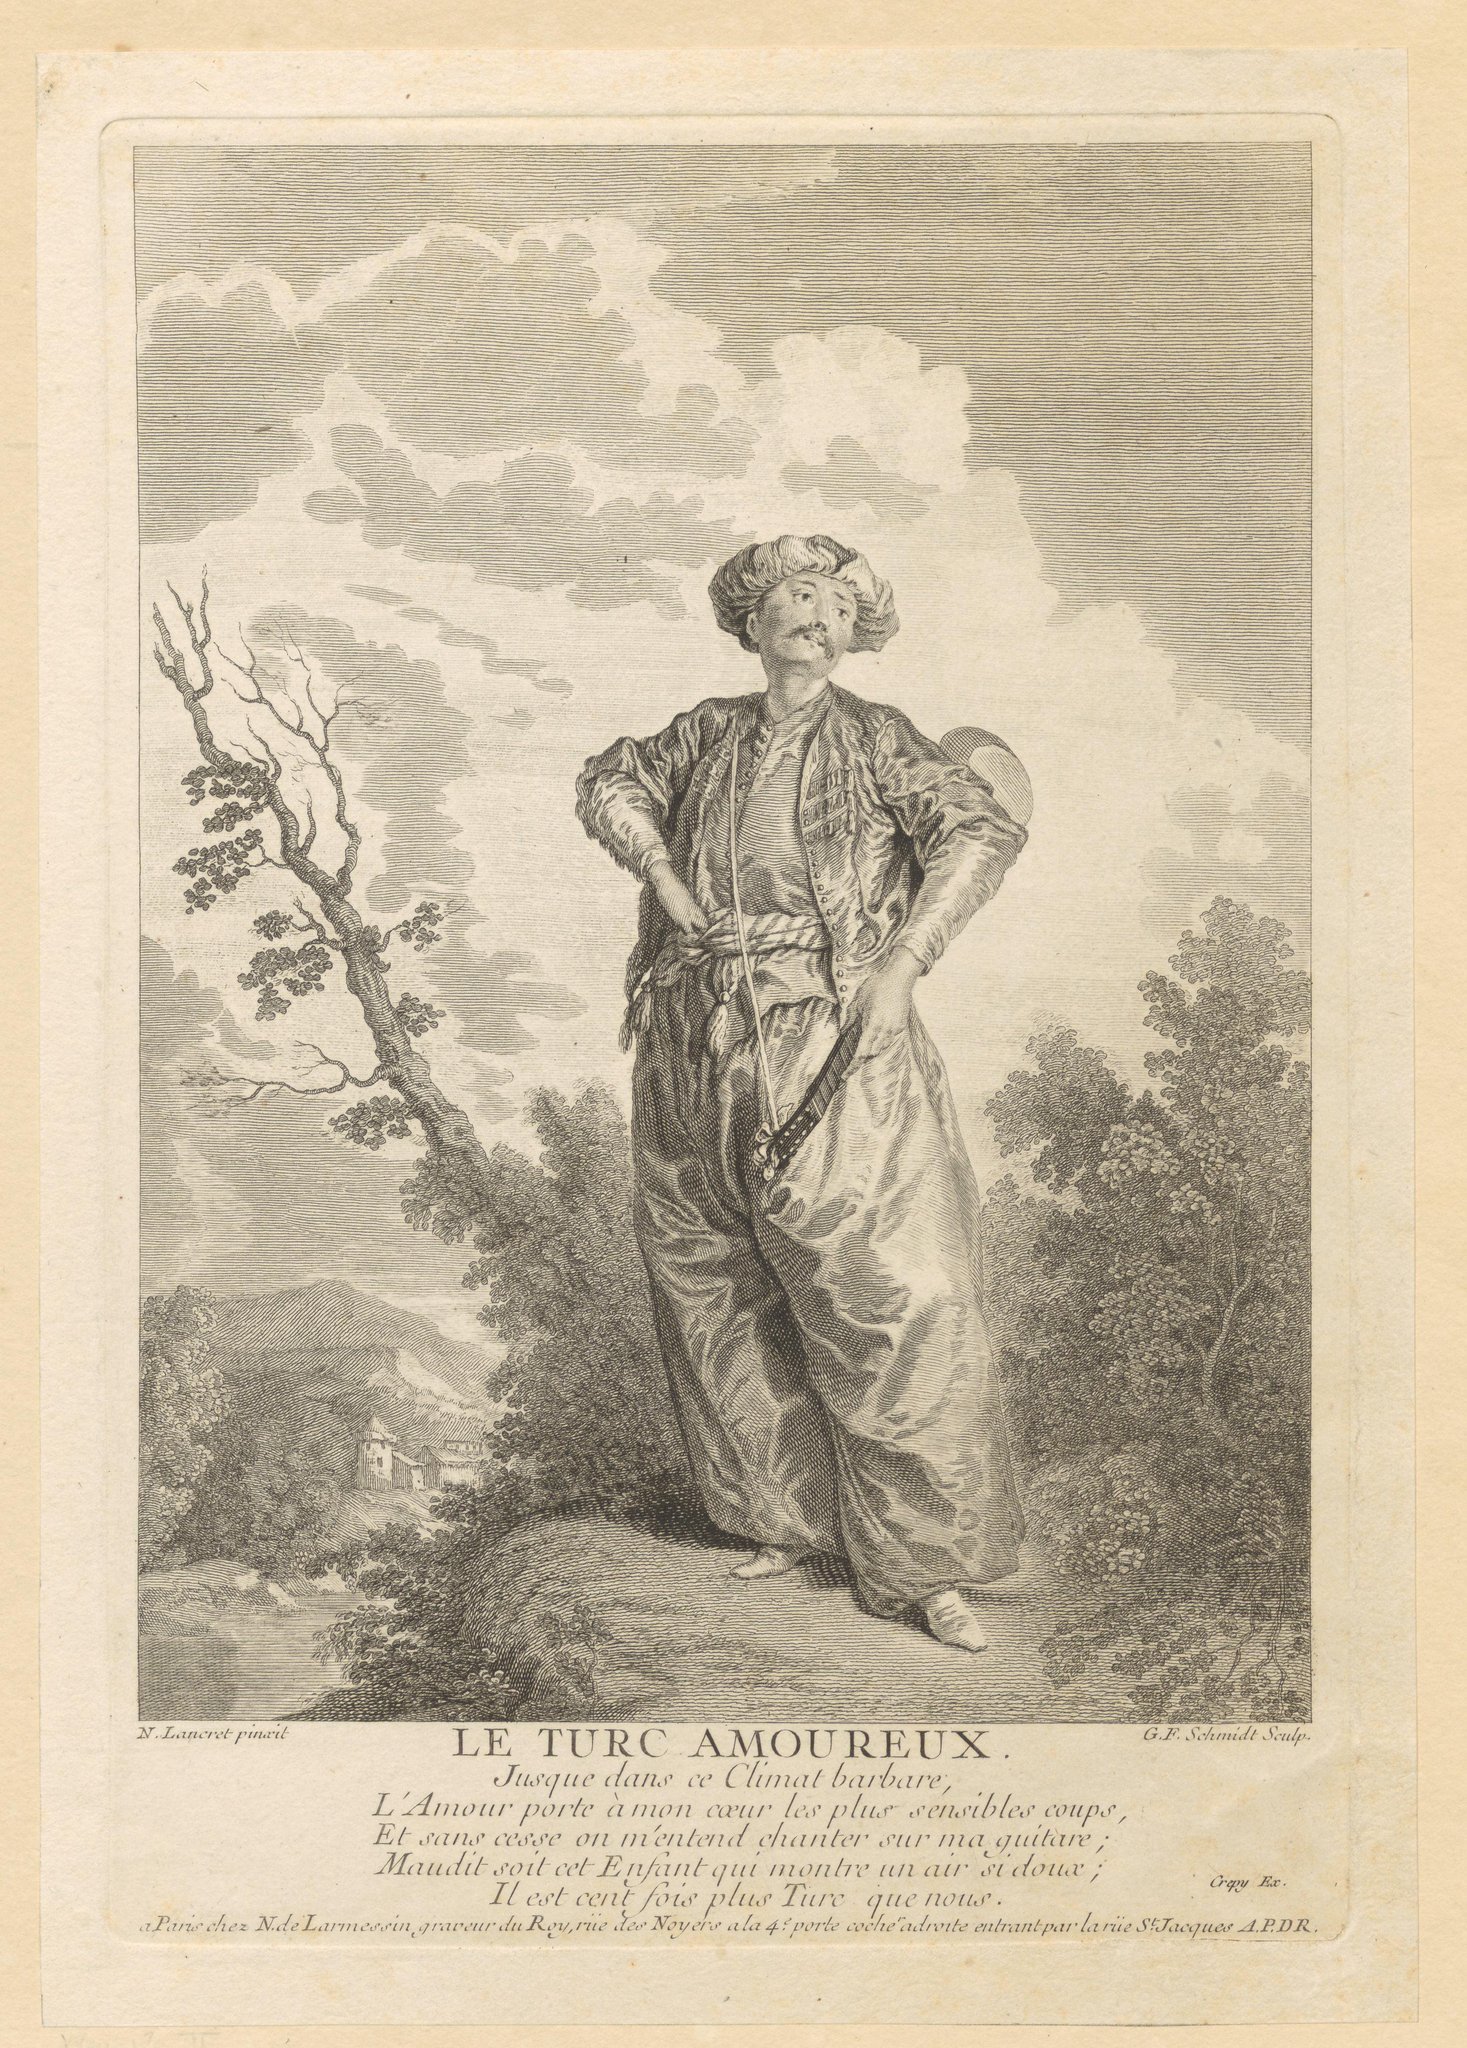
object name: print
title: Turkse man met snaarinstrument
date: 1722-1775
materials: paper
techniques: etching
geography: paris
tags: asiatic races and peoples: turks, string instruments (plucked), love: 'frau minne' and other allegories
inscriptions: collector's mark: Lugt 240